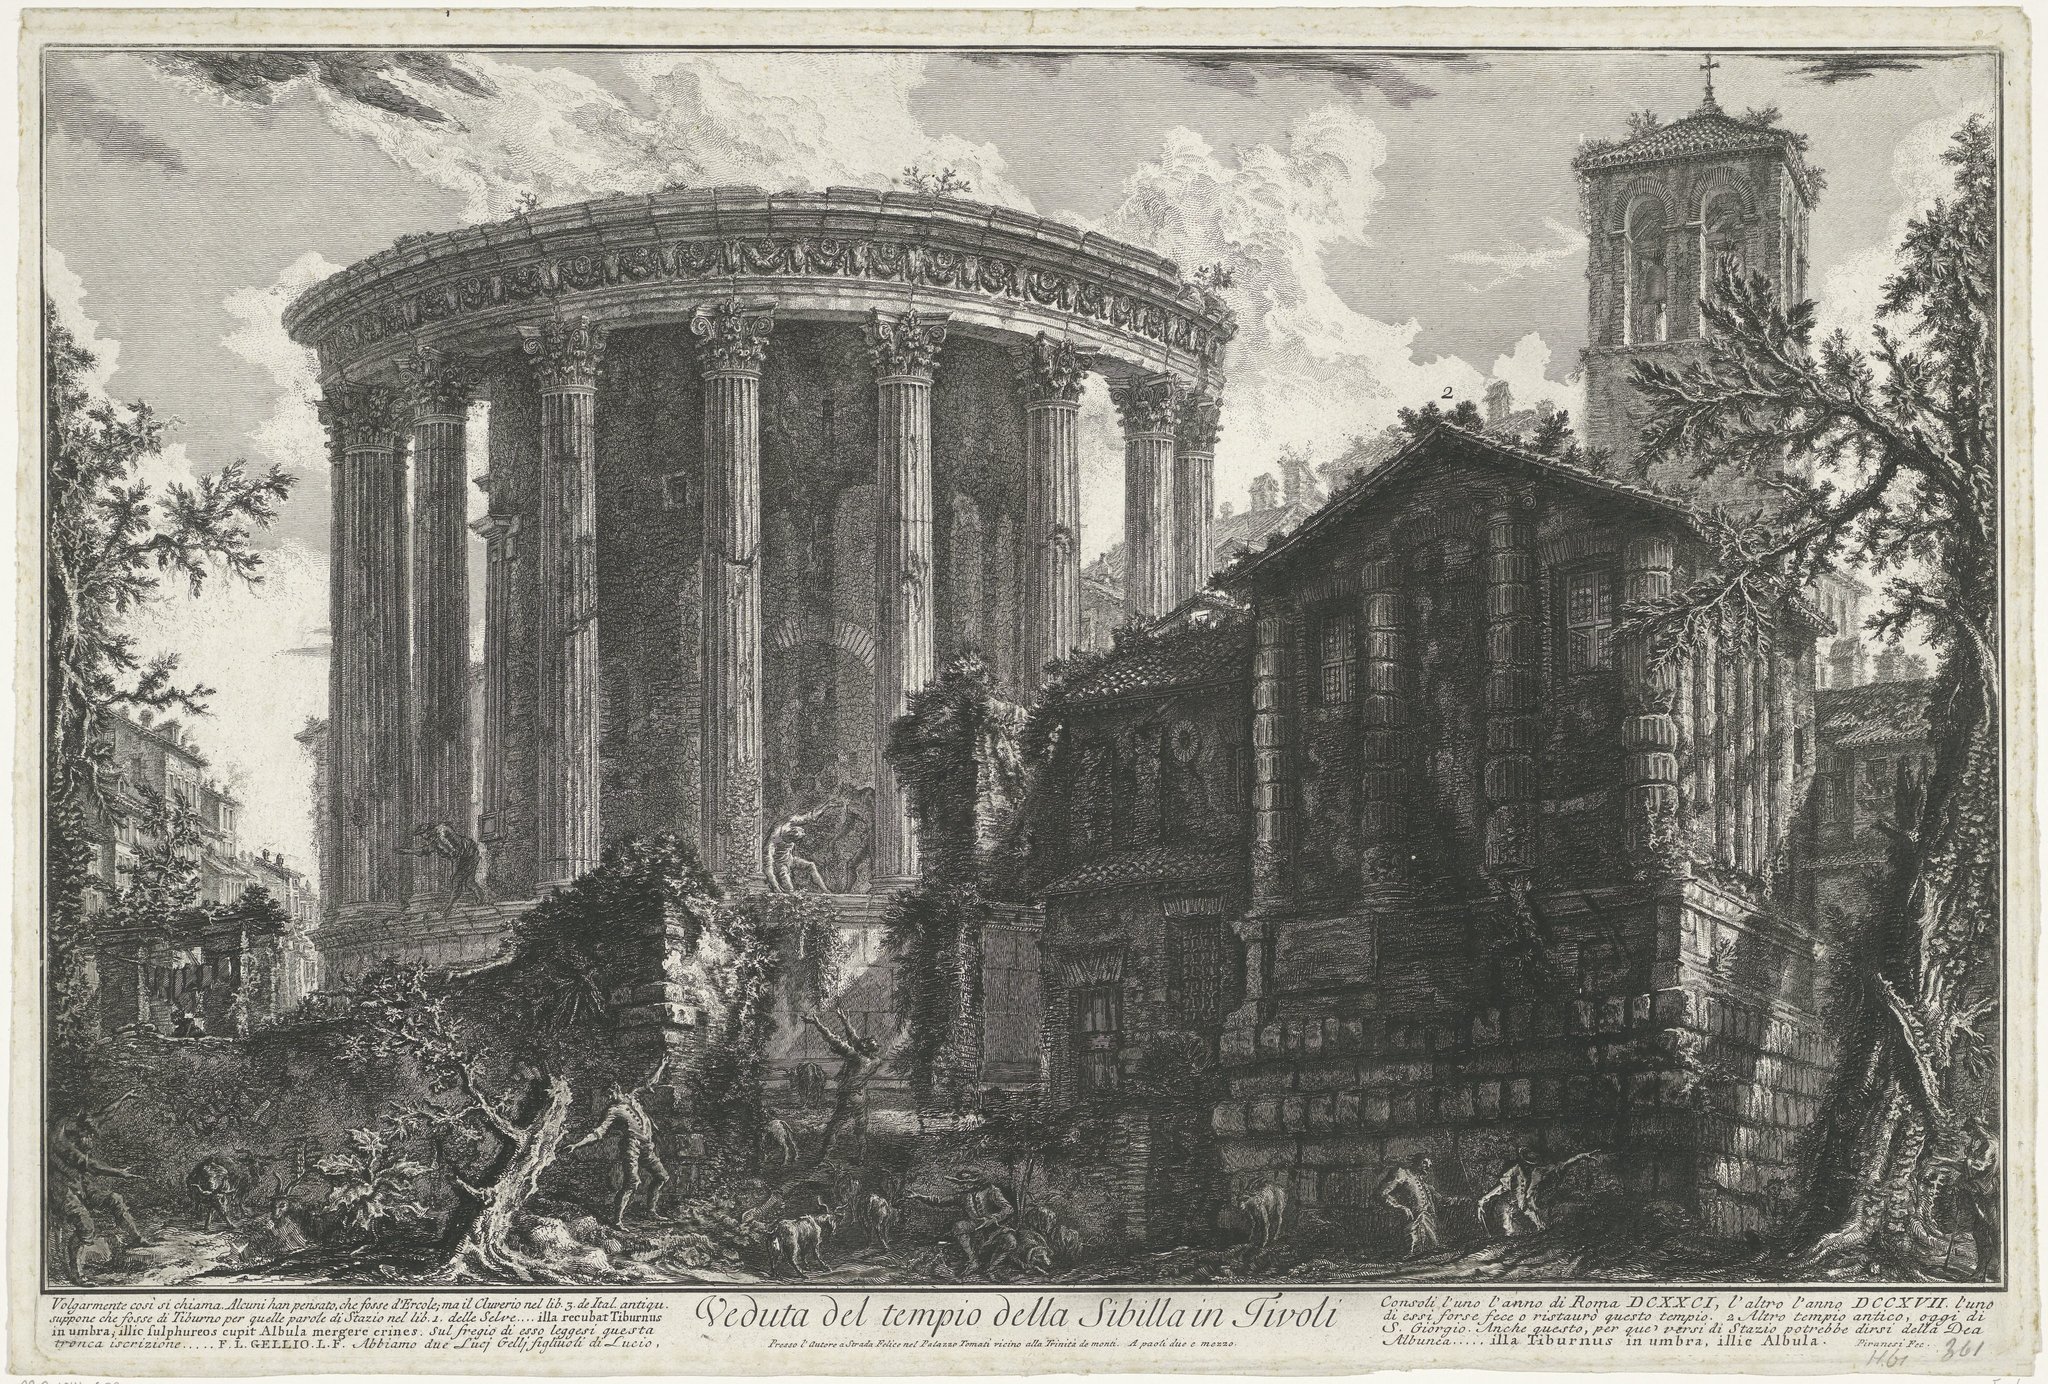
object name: print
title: Veduta del tempio della Sibilla in Tivoli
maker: giovanni battista piranesi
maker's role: designer, draughtsman, print maker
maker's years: 1720-1778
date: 1748-1778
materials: paper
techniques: etching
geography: rome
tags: city-view, and landscape with man-made constructions, ruin of a building ~ architecture, landscape with ruins, temple, shrine ~ roman religion, tivoli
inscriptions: collector's mark: Lugt 2228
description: Deze prent maakt deel uit van de serie 'Vedute di Roma'. Piranesi werkte aan deze 135 platen tellende serie tussen 1748 en zijn dood in 1778. Francesco Piranesi voegde later nog twee prenten toe aan de reeks van zijn vader.